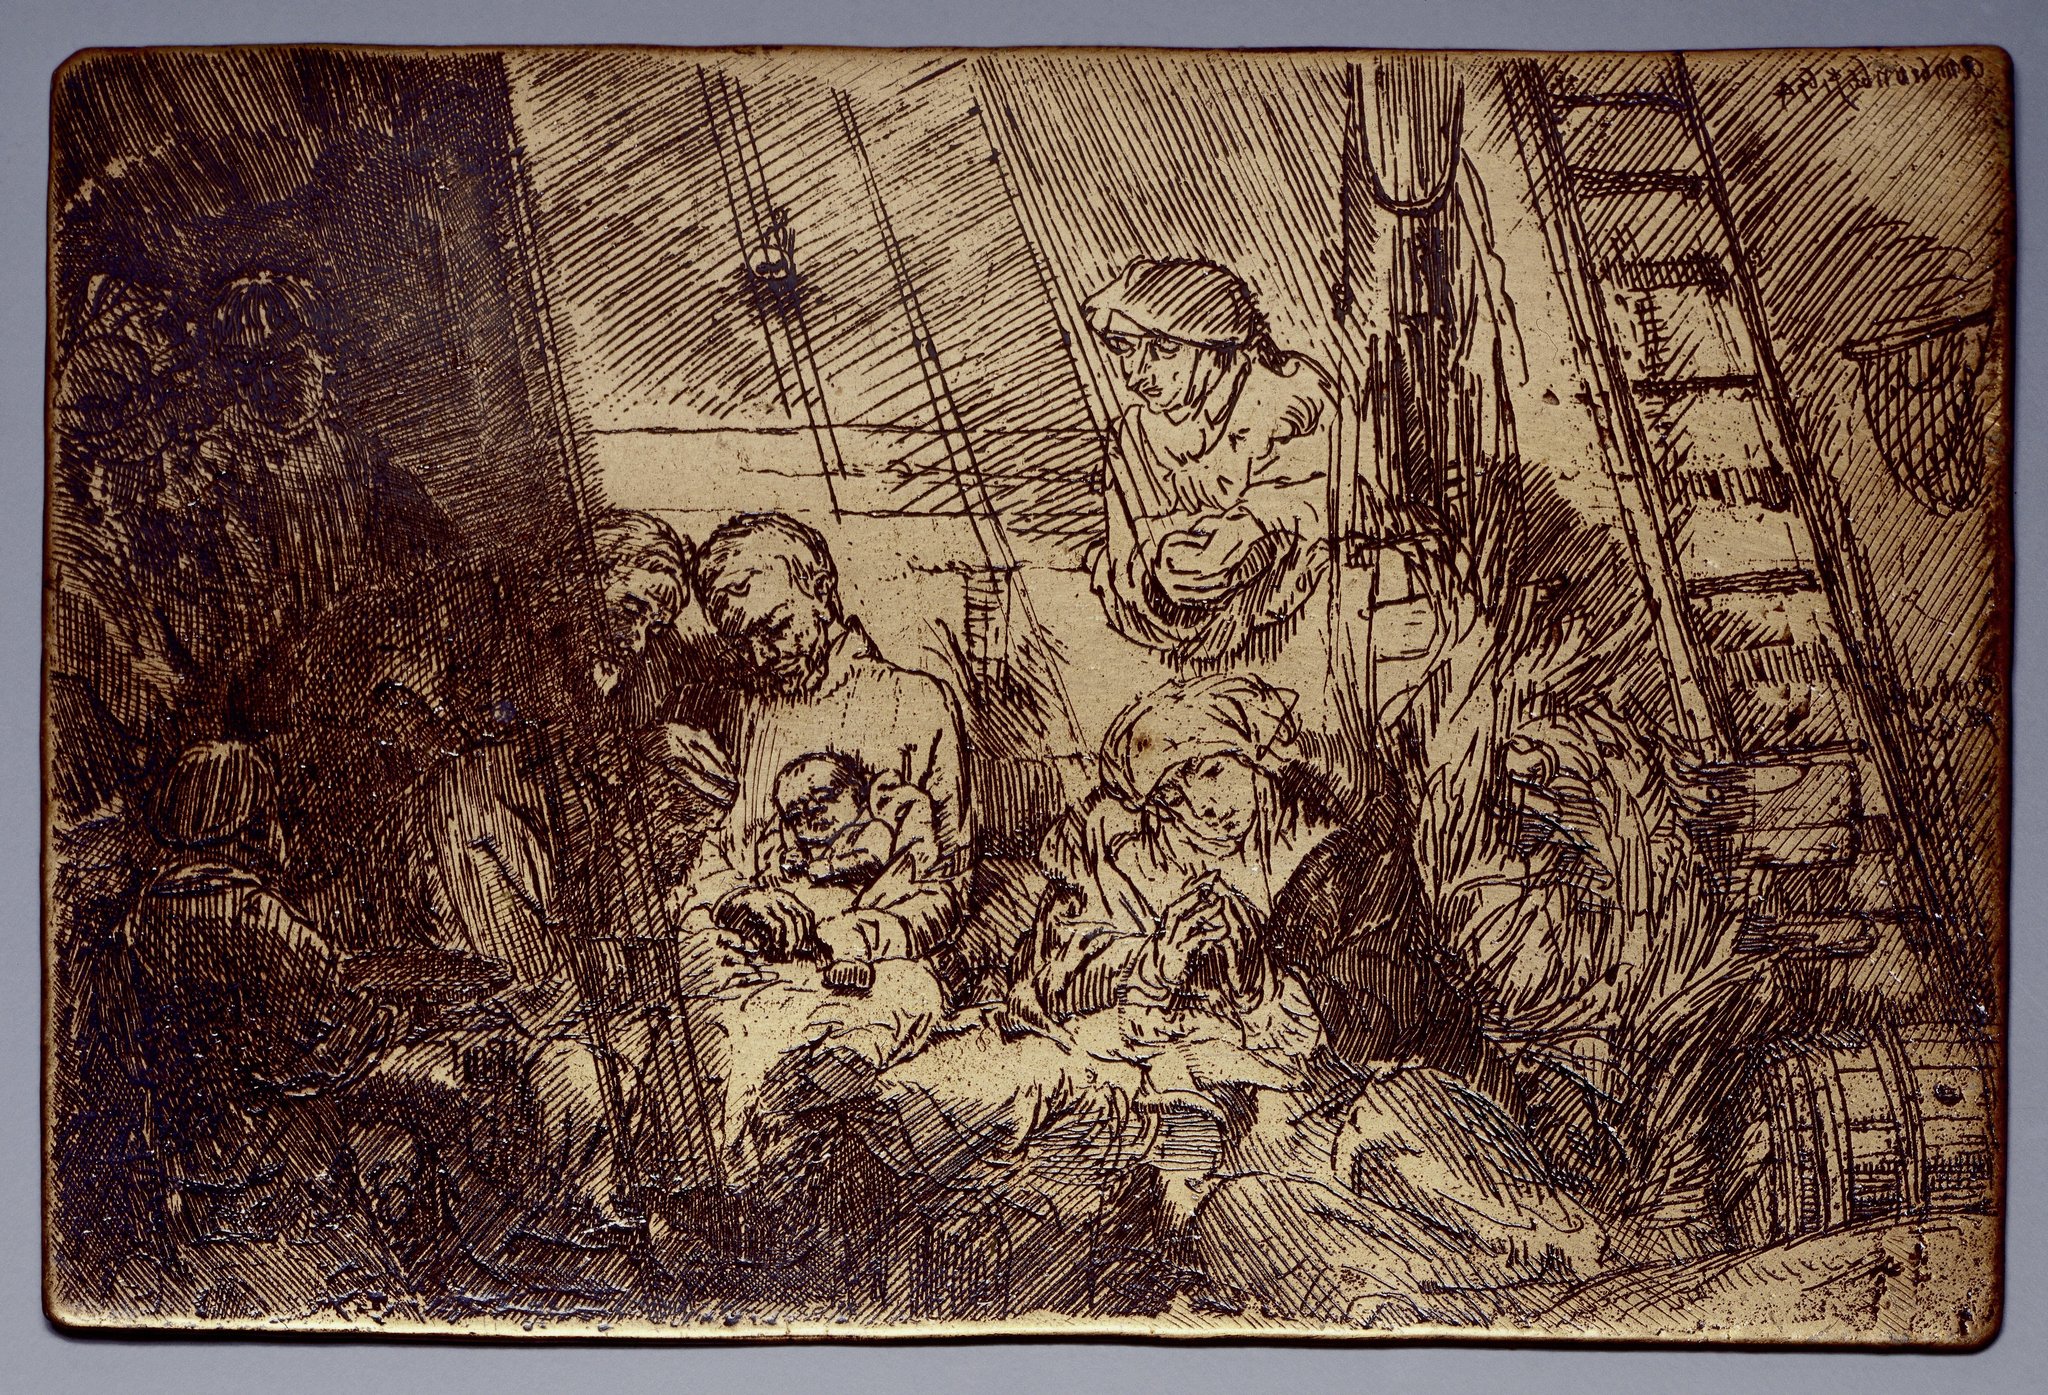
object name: copper plate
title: The Circumcision in the Stable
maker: rembrandt van rijn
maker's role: draughtsman, painter, print maker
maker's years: 1606-1669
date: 1654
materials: copper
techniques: etching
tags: circumcision of the christ-child by the priest in the temple (luke 2:21)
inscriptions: signature, date: ‘1654’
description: All of Rembrandt’s etchings are pulled from a copperplate. To make an etching, he would cover the plate with a mixture of resin and beeswax, then draw through that surface with a needle to expose the metal. The plate was immersed in acid, which ‘bites’ grooves in these exposed areas. When the plate was inked and put through a printing press with a sheet of paper, an impression of the design appears on the paper.